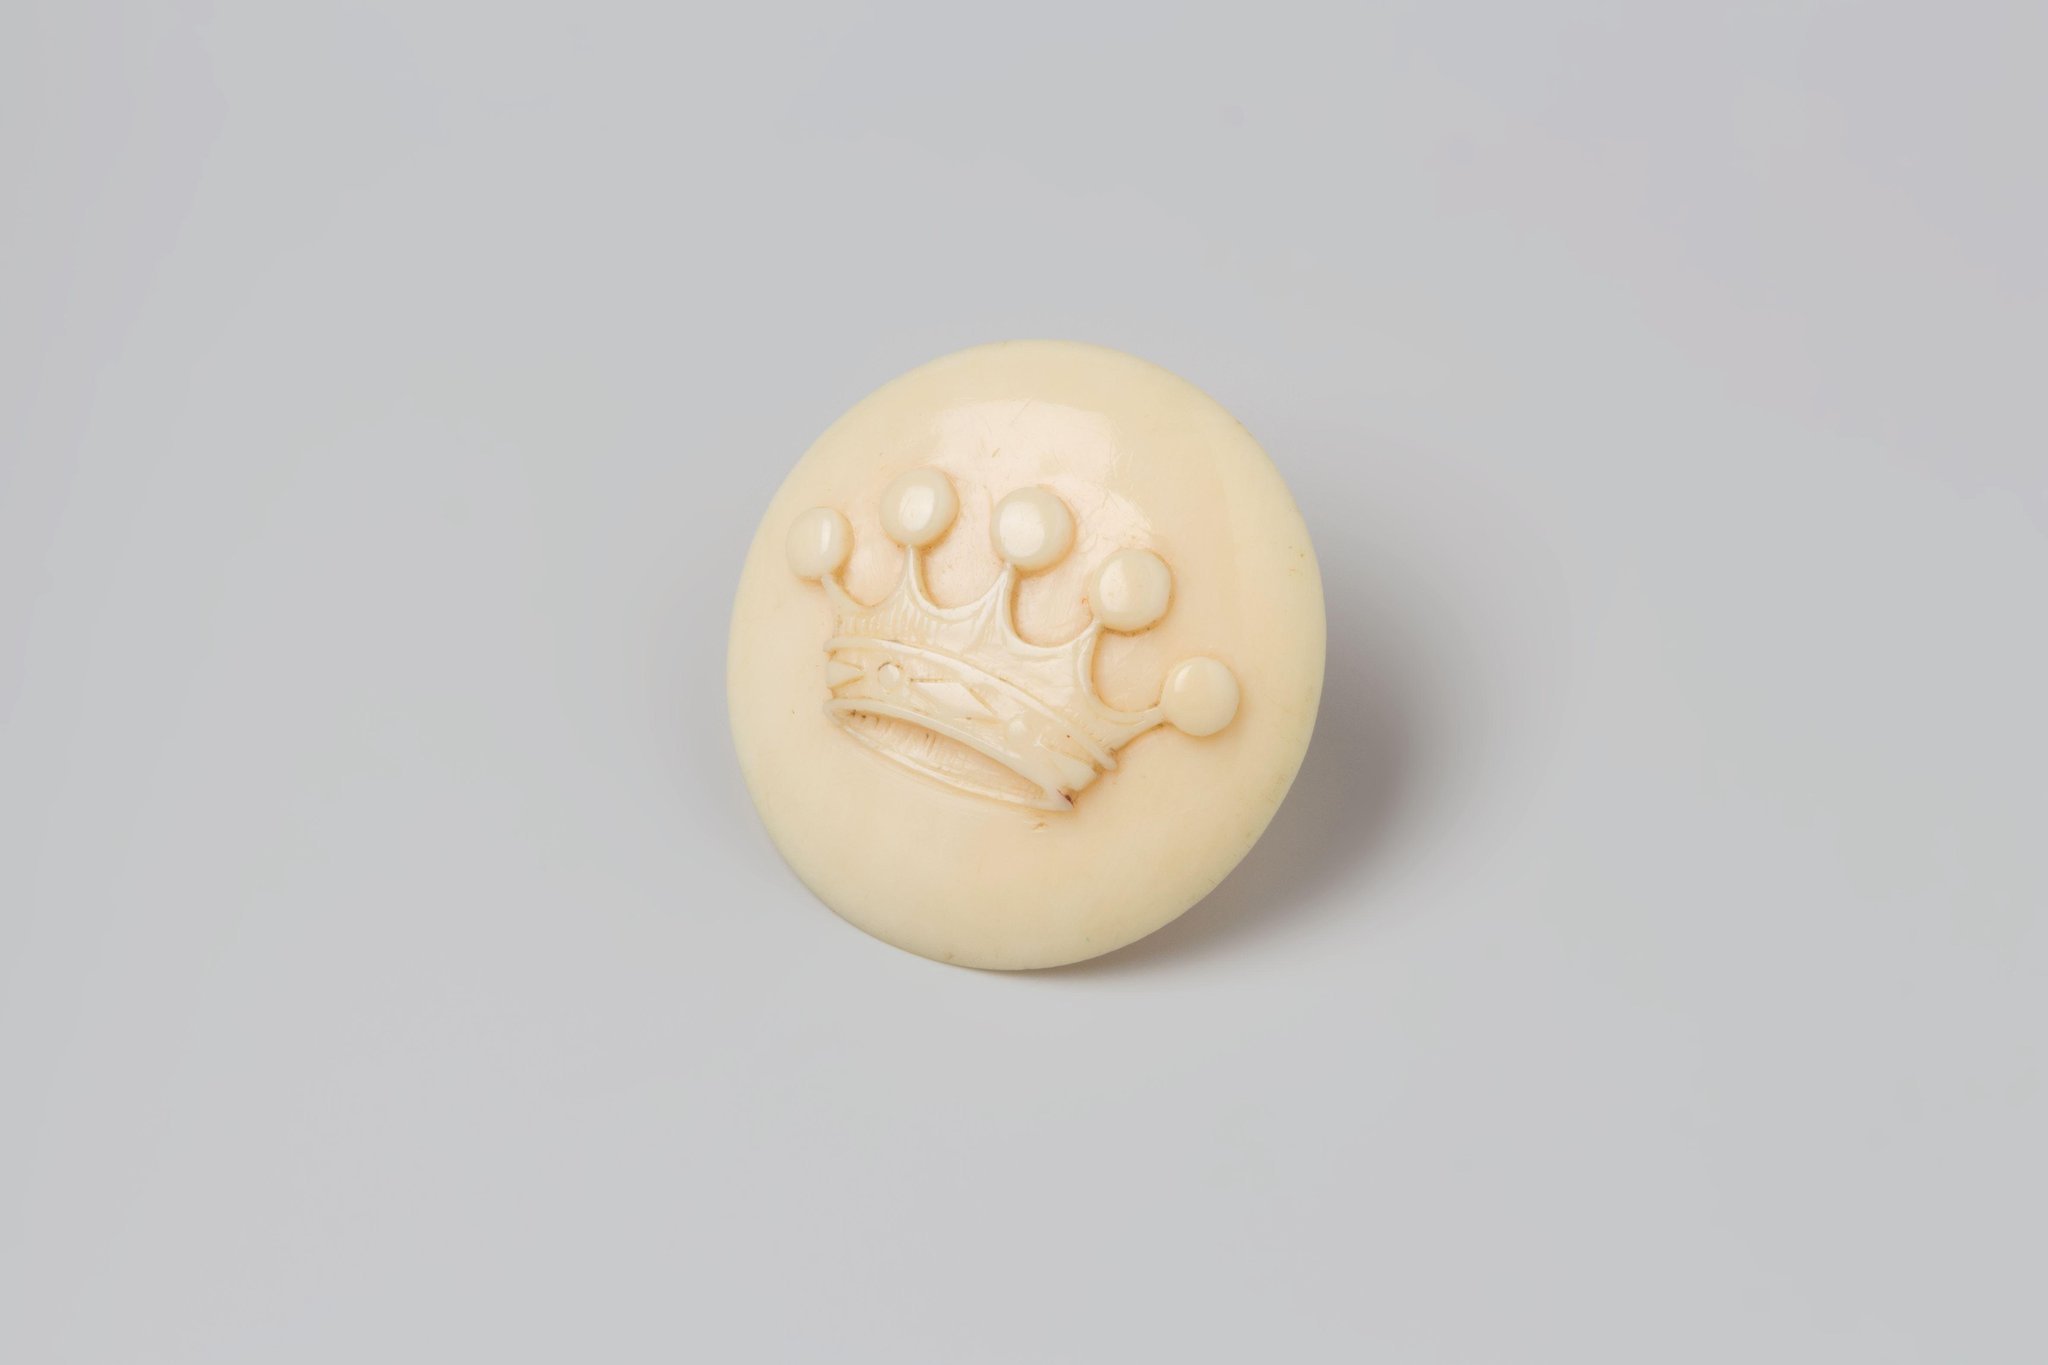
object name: button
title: Livreiknoop van ivoor, in reliëf gesneden met vijfpuntige kroon met parels (ridderskroon)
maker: Anonymous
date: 1800-1900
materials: ivory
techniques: cutting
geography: netherlands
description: Livreiknoop van ivoor, in reliëf gesneden met vijfpuntige kroon met parels (ridderskroon). Model: rond, met kleinere vaste tegenknoop.